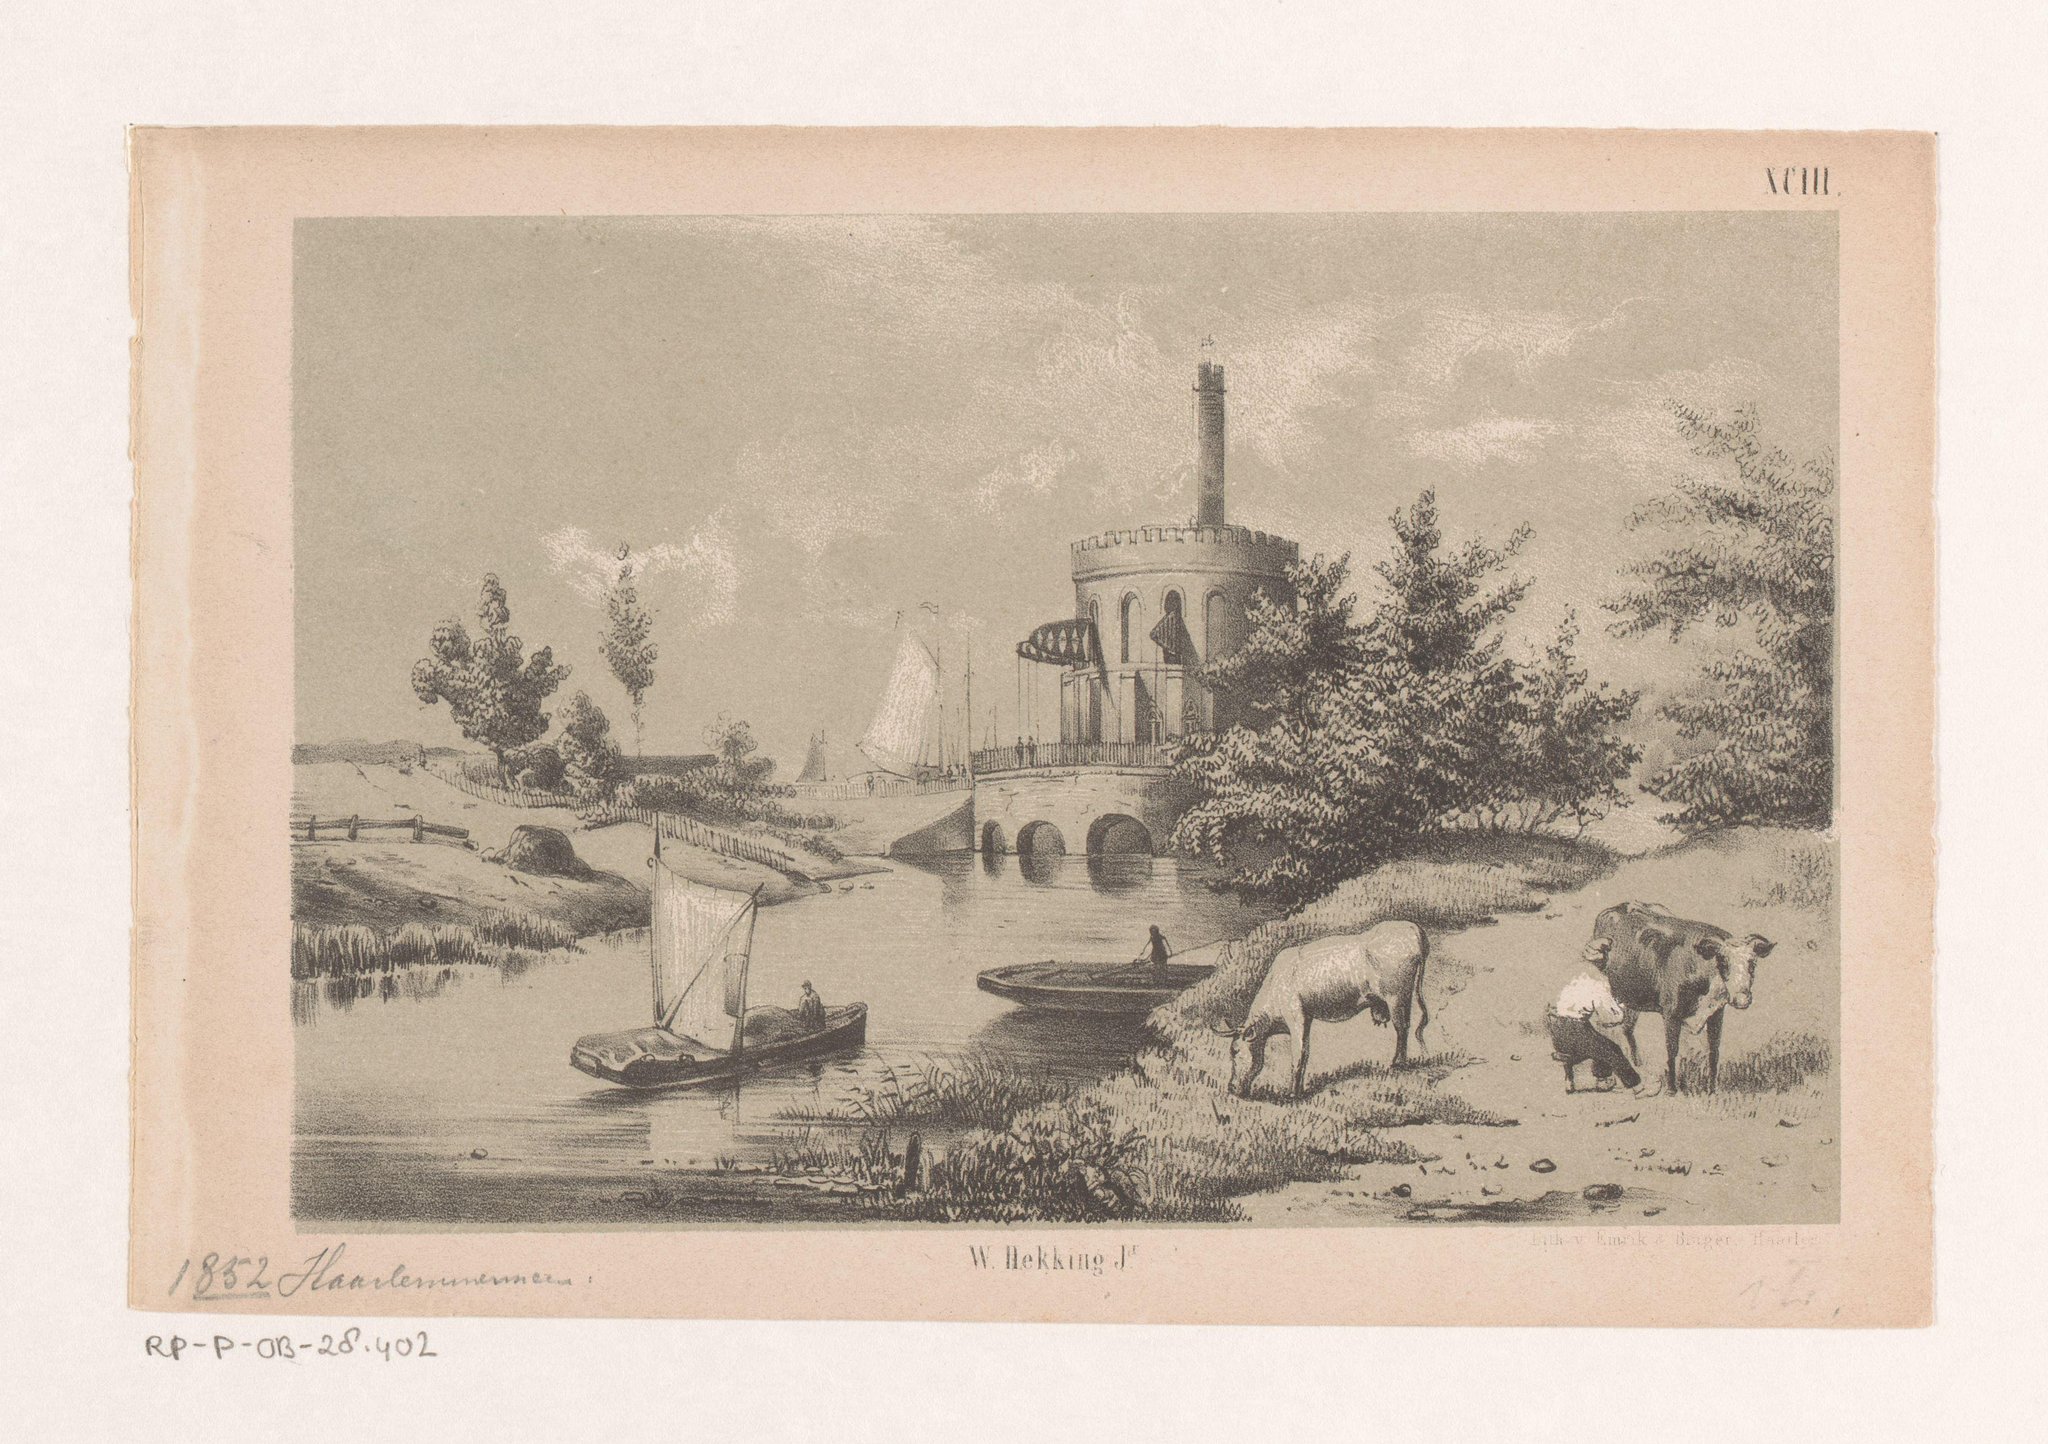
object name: print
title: Stoomgemaal De Cruquius in Haarlemmermeer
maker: willem hekking jr.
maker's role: print maker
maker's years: 1825-1904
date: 1857-1904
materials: paper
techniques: tone lithography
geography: haarlem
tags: pumping installation, pumping-engine (~ polder) (+ landscape with figures, staffage), cow (+ animals used as cattle, livestock)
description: Het gemaal is gezien vanaf het water. Rechts op de kant wordt een koe gemolken door een boer. De prent is genummerd, rechtsboven: XCIII.